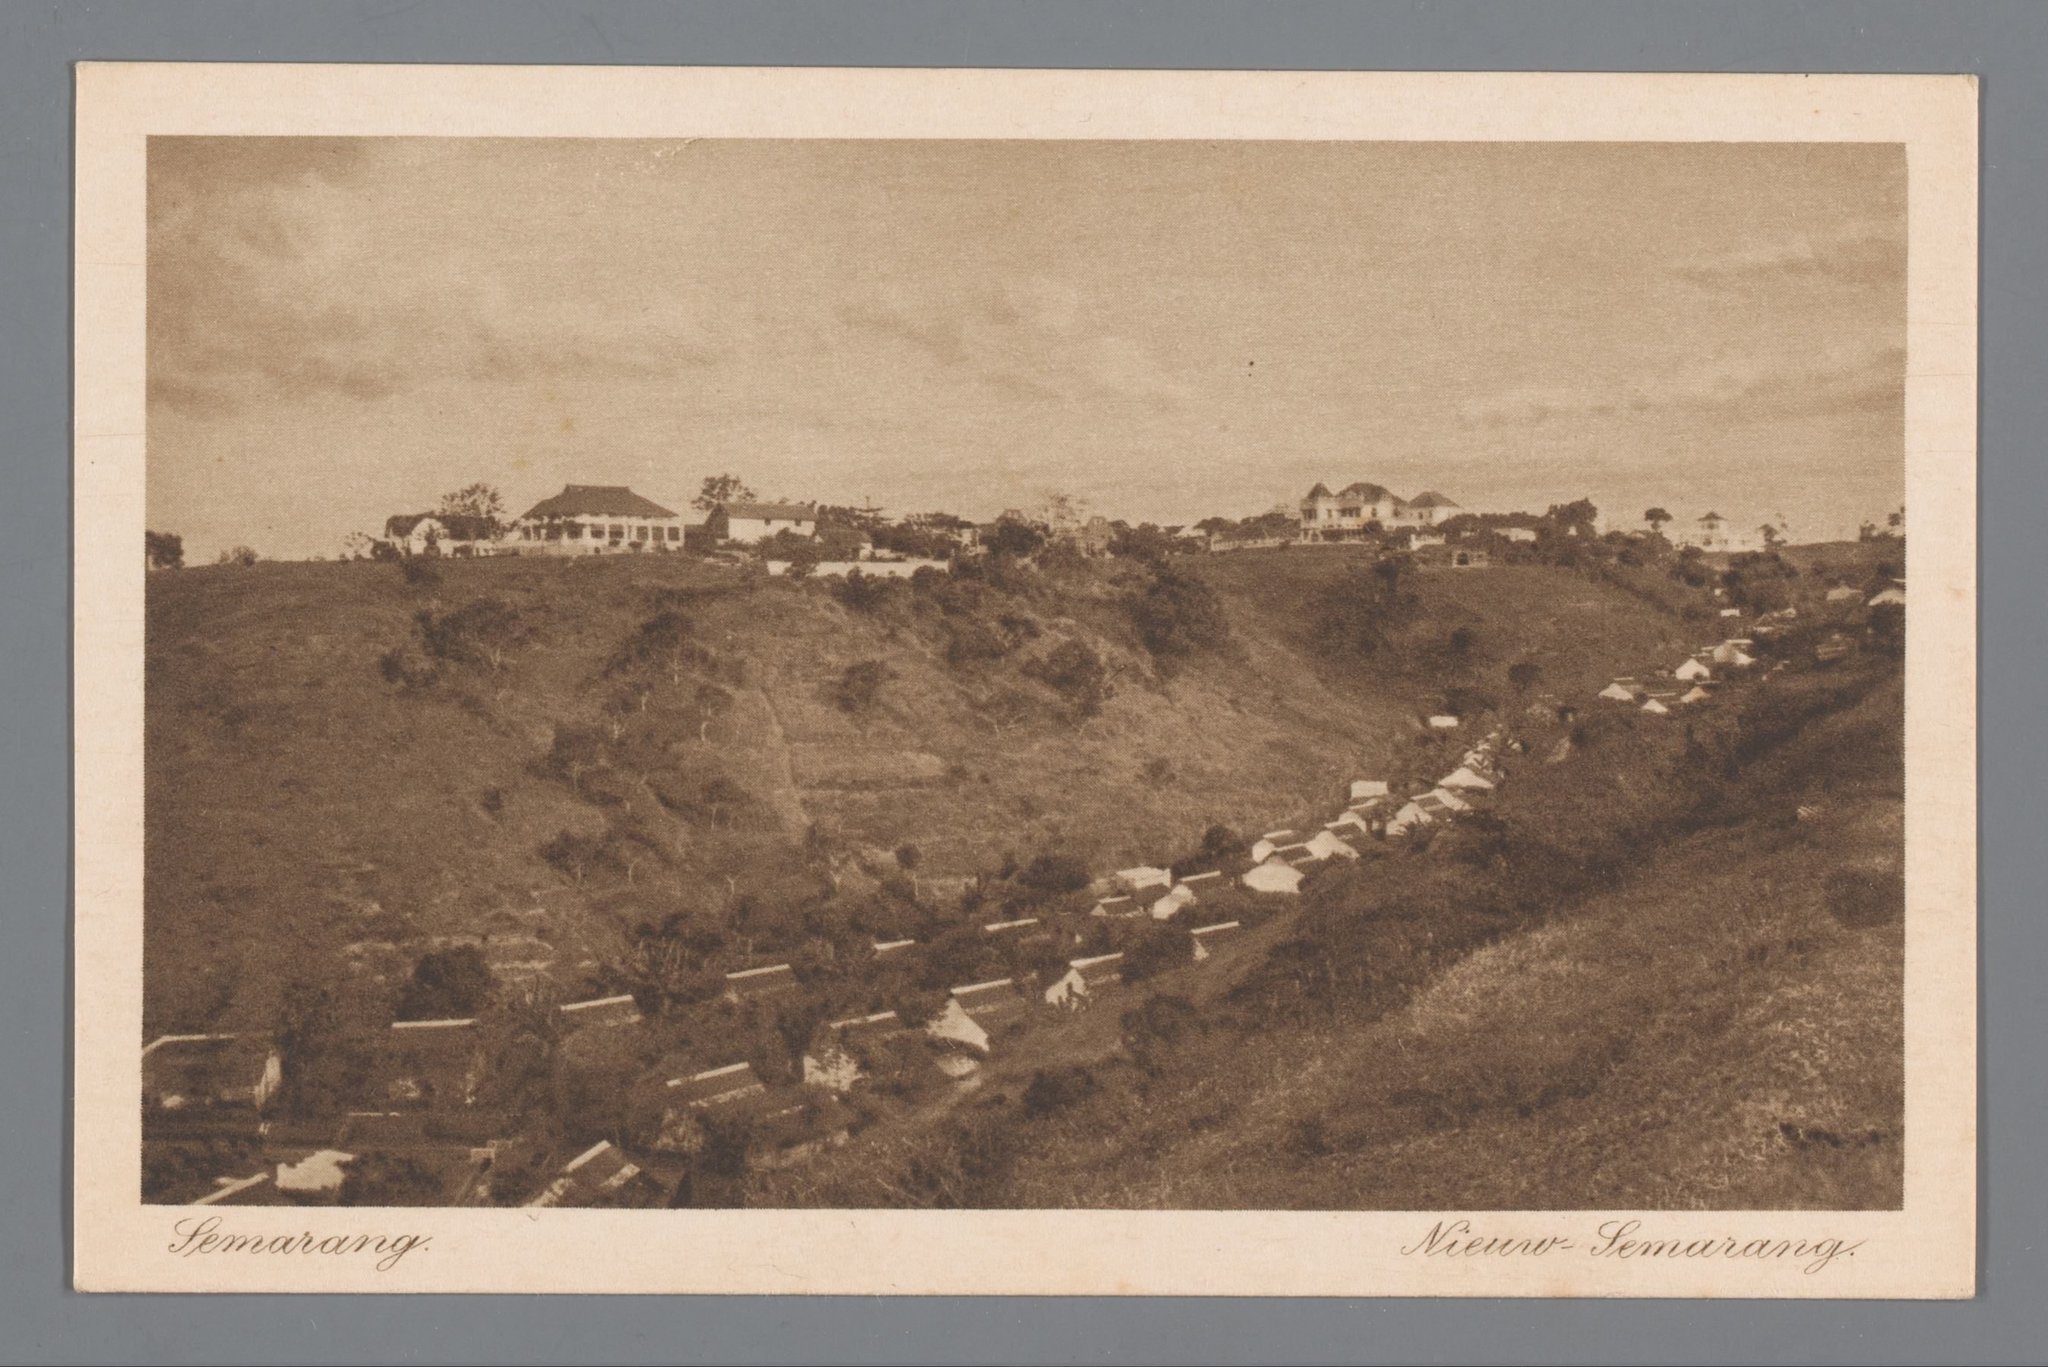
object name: photograph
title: Semarang. Nieuwe Semarang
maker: otto hisgen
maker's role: fotograaf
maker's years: 1874-1944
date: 1900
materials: paper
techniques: photography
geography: semarang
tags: dutch east indies, the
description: Eén van zes briefkaarten, foto's in bruin, stadsgezichten van Nieuw-Semarang; achterzijde onbeschreven. Semarang ligt op midden-Java. Opmerking: zie NG-1011-A t/m F.